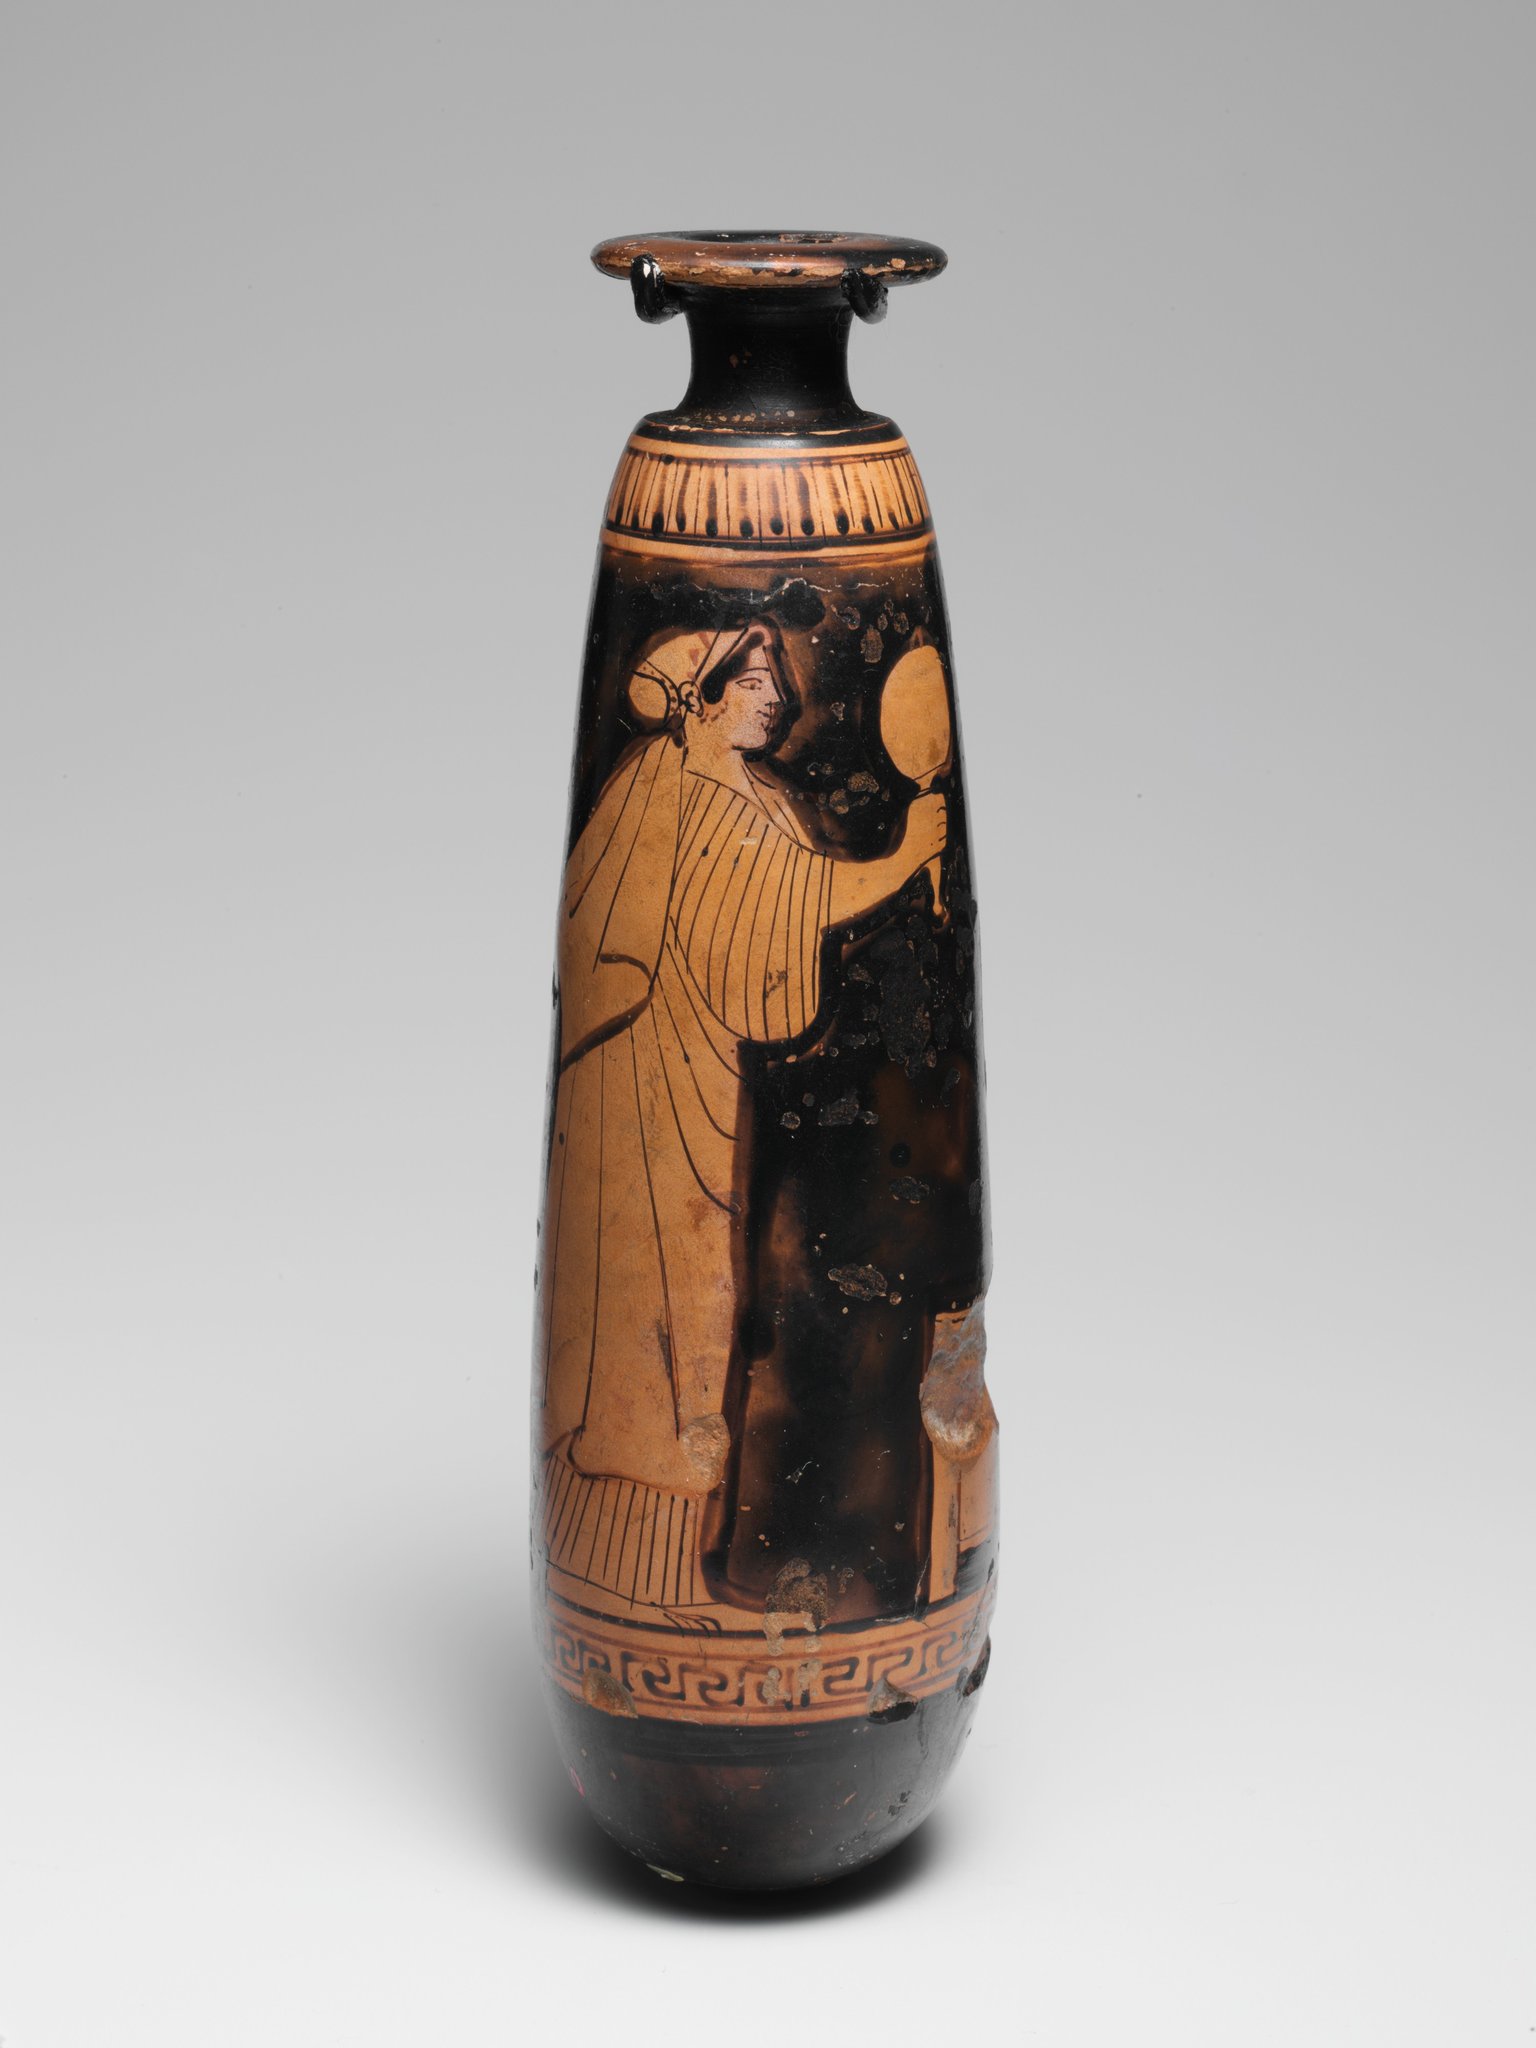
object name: alabastron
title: Terracotta alabastron (perfume vase)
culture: greek, attic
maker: beth pelet painter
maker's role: artist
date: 460 BCE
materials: terracotta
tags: women,mirrors